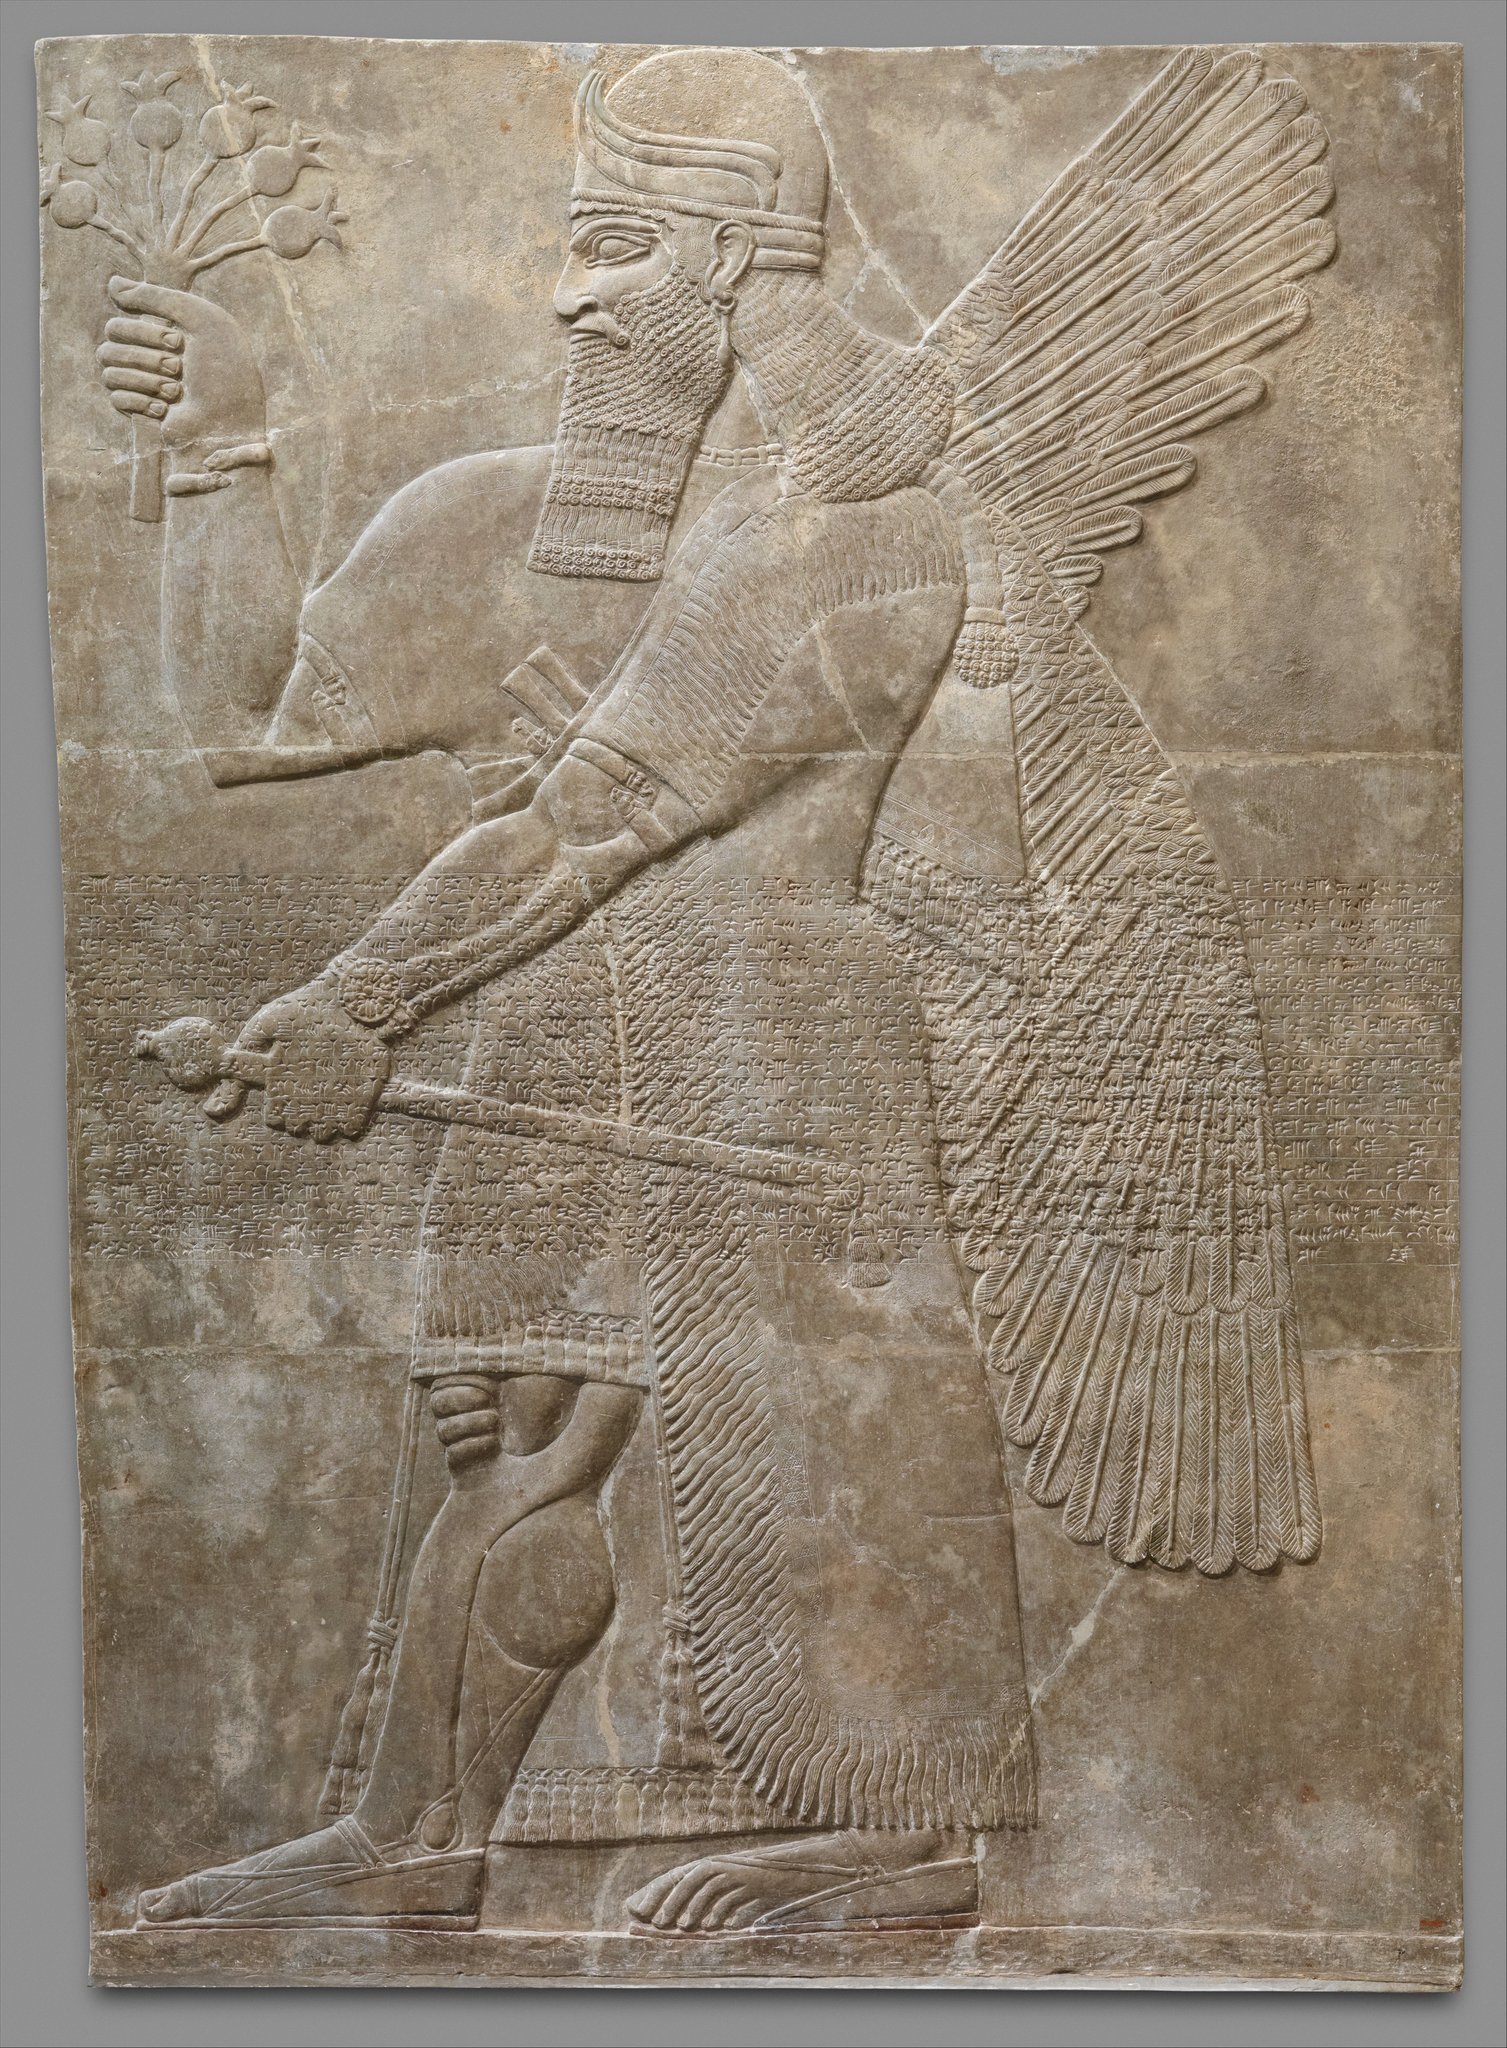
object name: relief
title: Relief panel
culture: assyrian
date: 883-859 BCE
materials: alabaster, gypsum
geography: mesopotamia